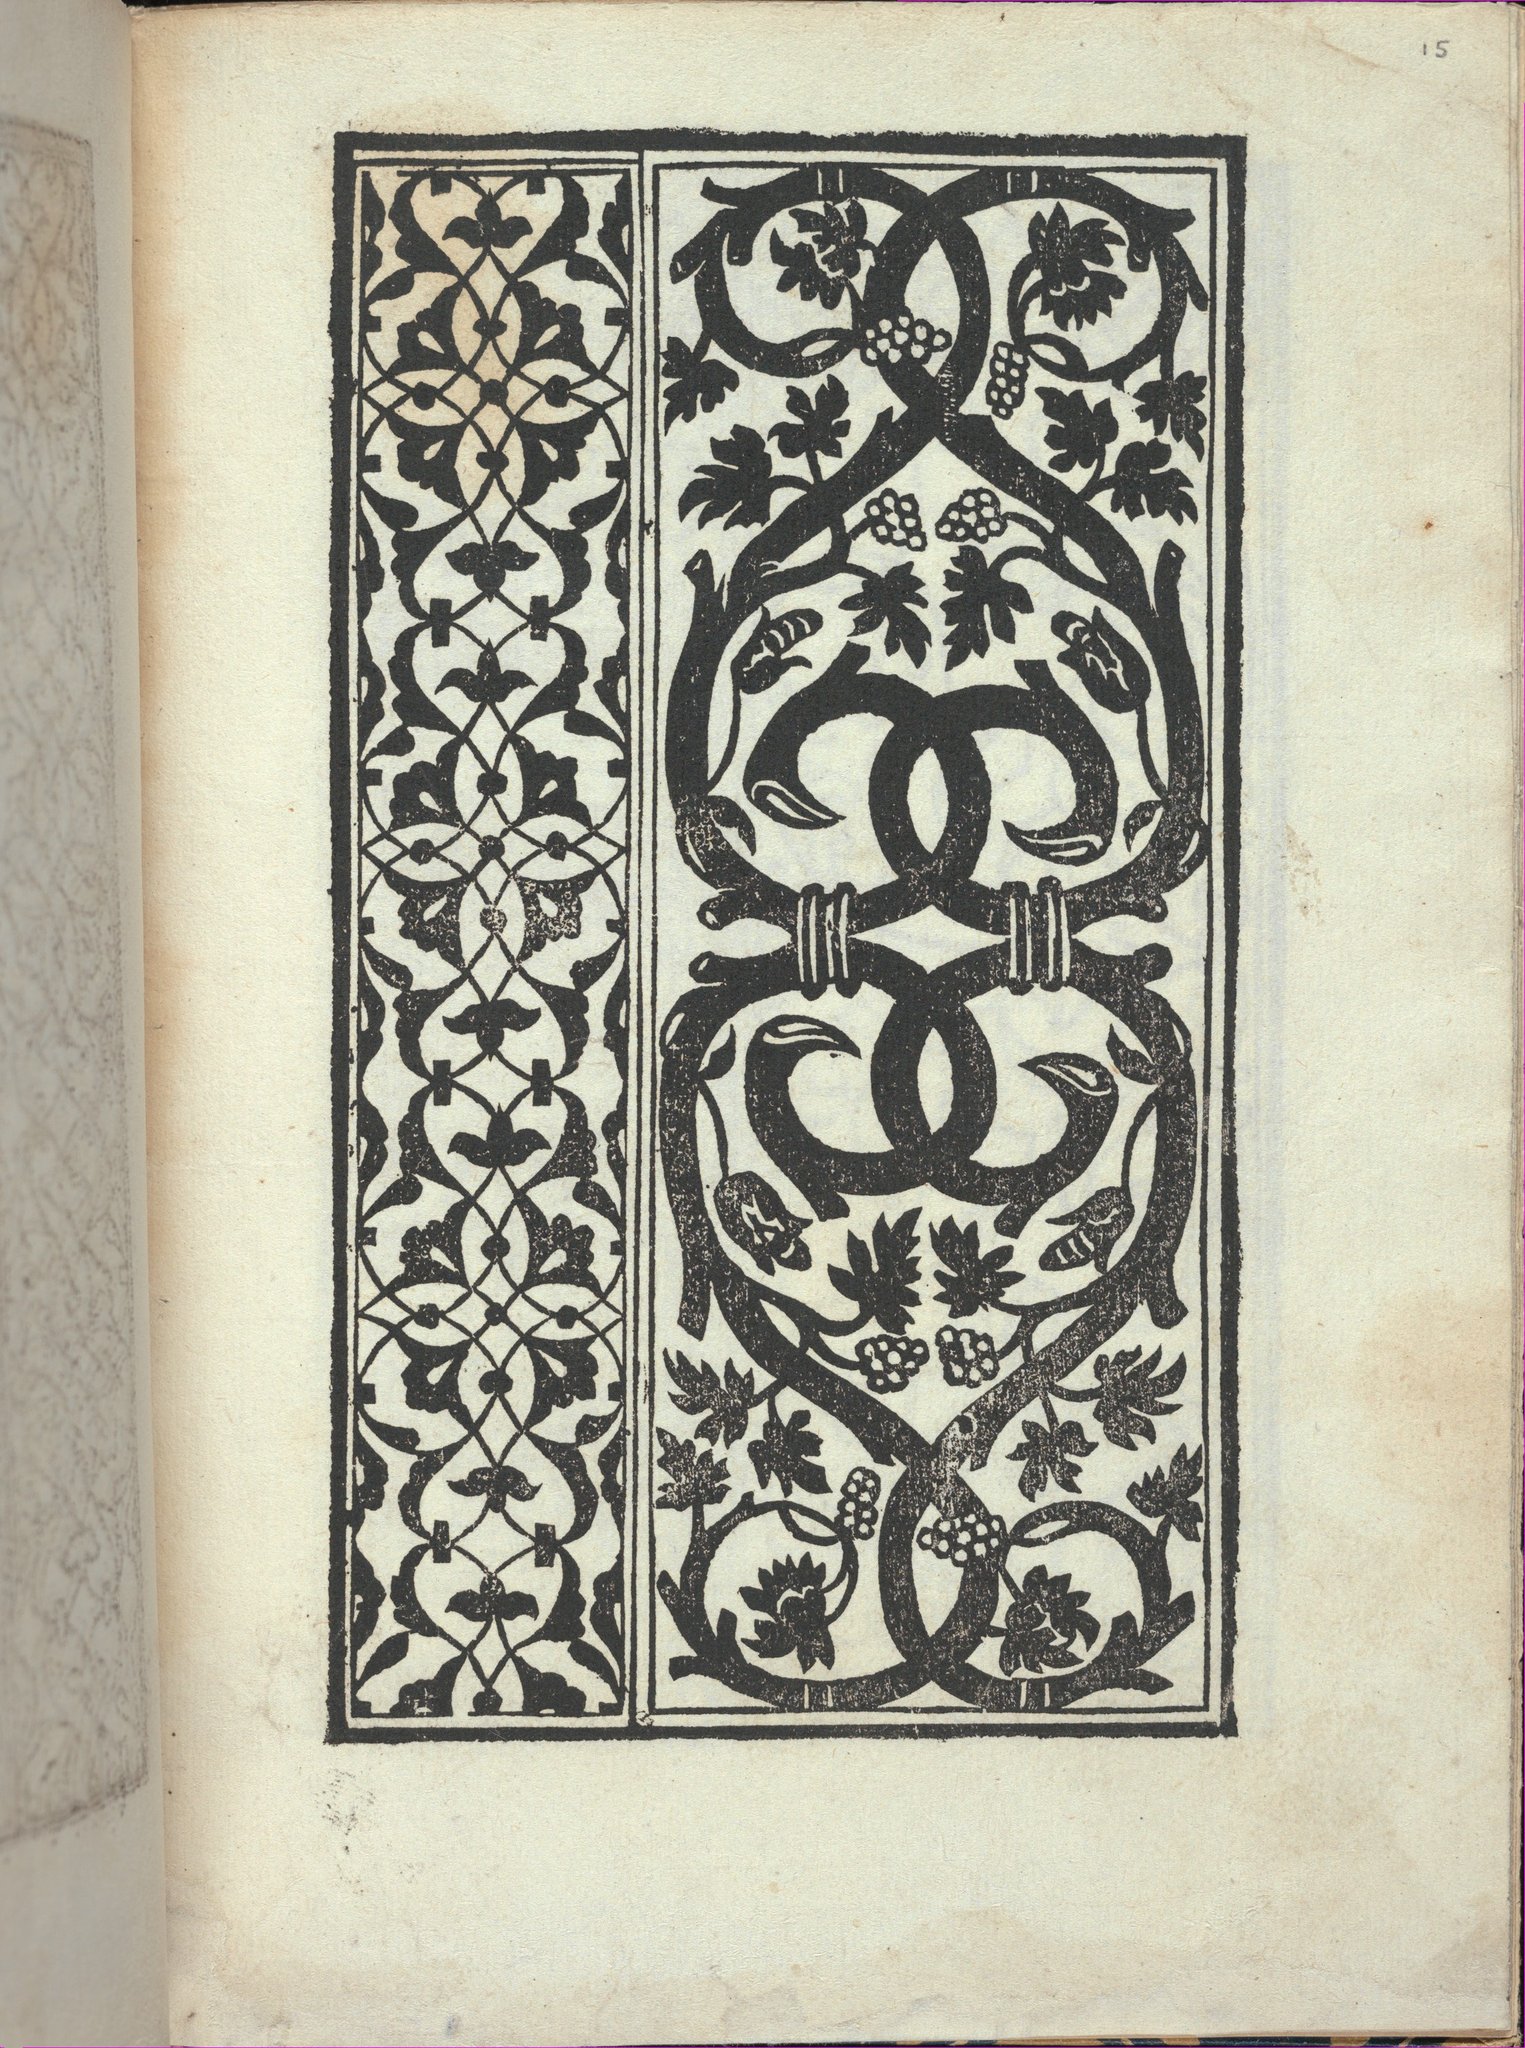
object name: book print ornament architecture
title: Libro quarto. De rechami per elquale se impara in diuersi modi lordine e il modo de recamare...Opera noua, page 15 (recto)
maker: alessandro paganino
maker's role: publisher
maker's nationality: italian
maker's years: 1500-1550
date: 1532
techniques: woodcut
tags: vines